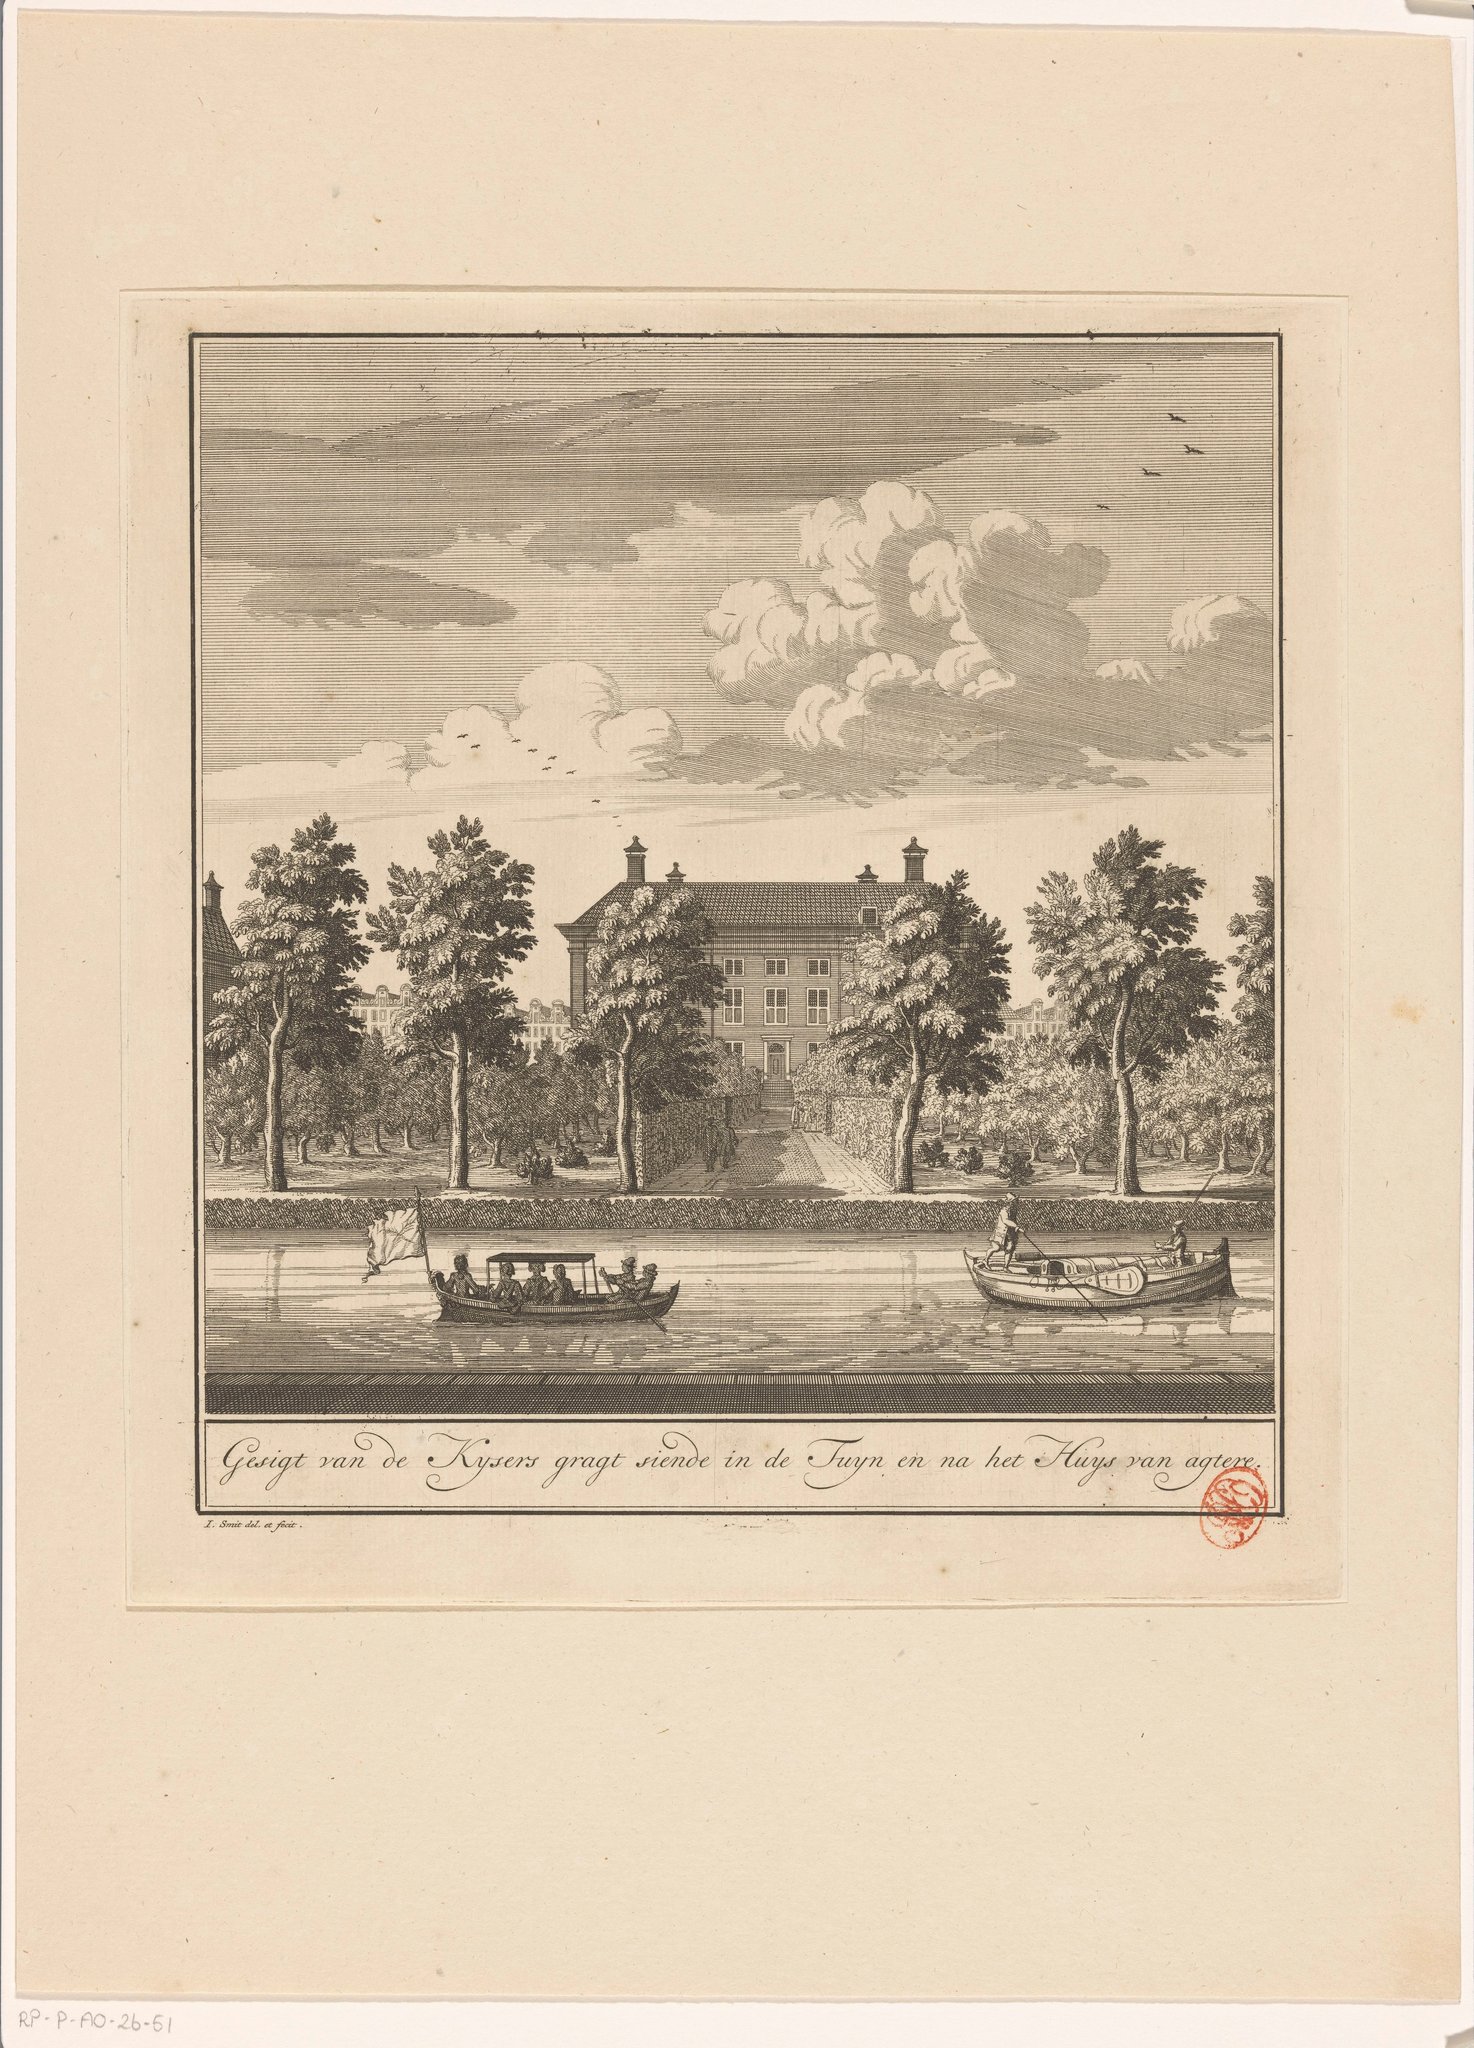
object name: print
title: Gesigt van de Kysers gragt siende in de Tuyn en na het Huys van agtere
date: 1723-1748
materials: paper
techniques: engraving, etching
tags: alms-house (dutch: 'hofje'), public welfare, french or architectonic garden; formal garden, rowing-boat, canoe, etc., orchard, canals, waters (in city) (+ city(-scape) with figures, staffage), old-people's home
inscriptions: collector's mark: Lugt 195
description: Gezicht op de tuin en de achtergevel het Corvershof aan de Nieuwe Herengracht te Amsterdam, gezien vanaf de Nieuwe Keizersgracht. Aan weerszijden van het middenpad een boomgaard. In de gracht twee boten. Onderdeel van een serie prenten van het in 1723 in gebruik genomen Corvershof, bestemd voor oudere echtparen van Nederduits Gereformeerde (later Hervormde) huize.